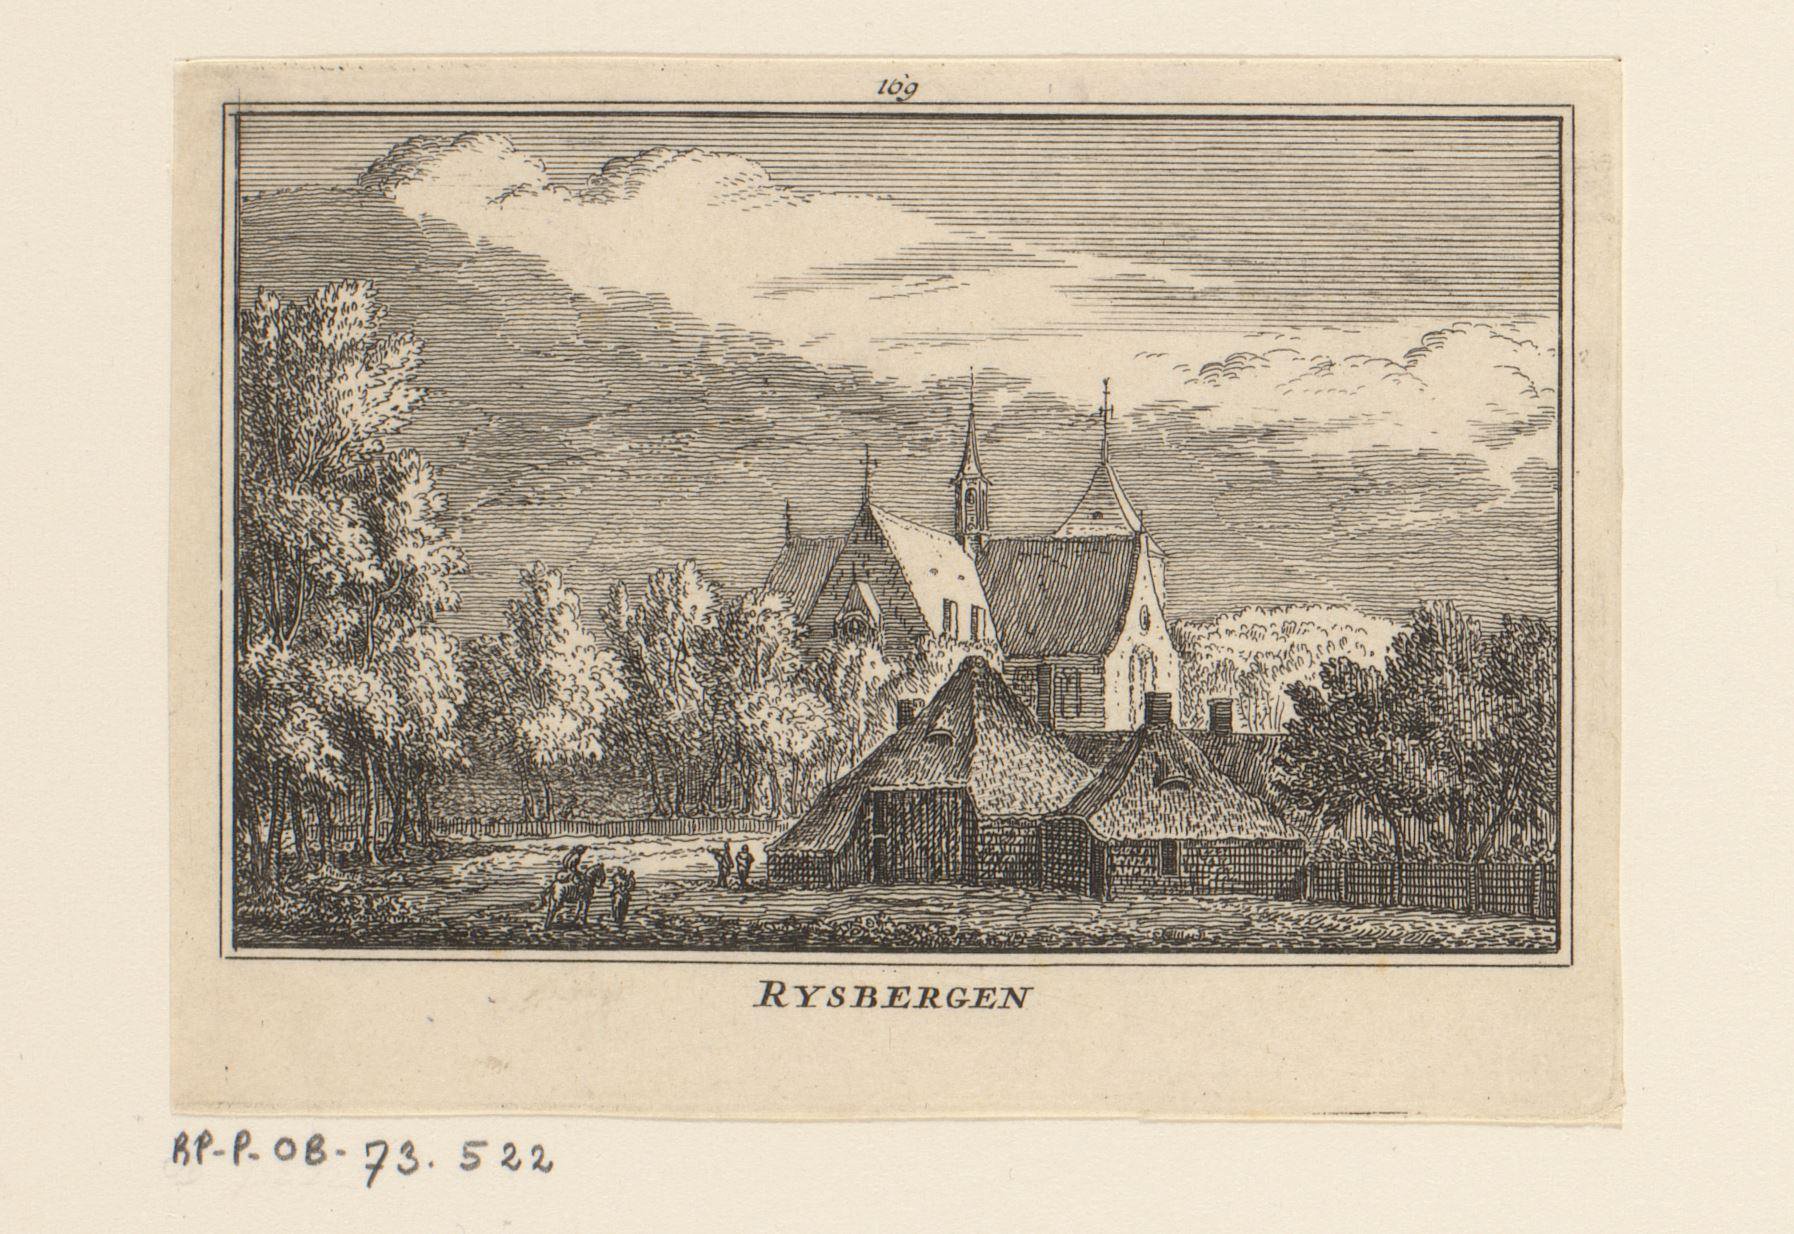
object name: print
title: Rysbergen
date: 1725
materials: paper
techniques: etching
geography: amsterdam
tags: church (exterior), farm (building)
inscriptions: collector's mark: Lugt 2228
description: Prent ook gebruikt in: Kabinet van Nederlandsche outheden en gezichten: vervat in 300 konstplaaten, verzamelt, getekent en in 't koper gebragt door den Konst-ryken Abraham Rademarker. Met eene korte beschryving der zelve in het Duitsch, Fransch en Engelsch, Amsterdam: Willem Barents, 1725, ill. nr. 169. In 1972 identificeerde Y.P.W. van der Werff deze kerk als de St. Willibrordkerk van het nabijgelegen Klein-Zundert. Uit andere afbeeldingen van die kerk blijkt echter dat de bouw afwijkt van de hier getoonde. Waar de St. Willibrorduskerk alleen een smalle spits had op het westwerk, heeft de kerk op deze prent een spits met klok erin op de viering en nog een dikkere toren aan het westwerk.